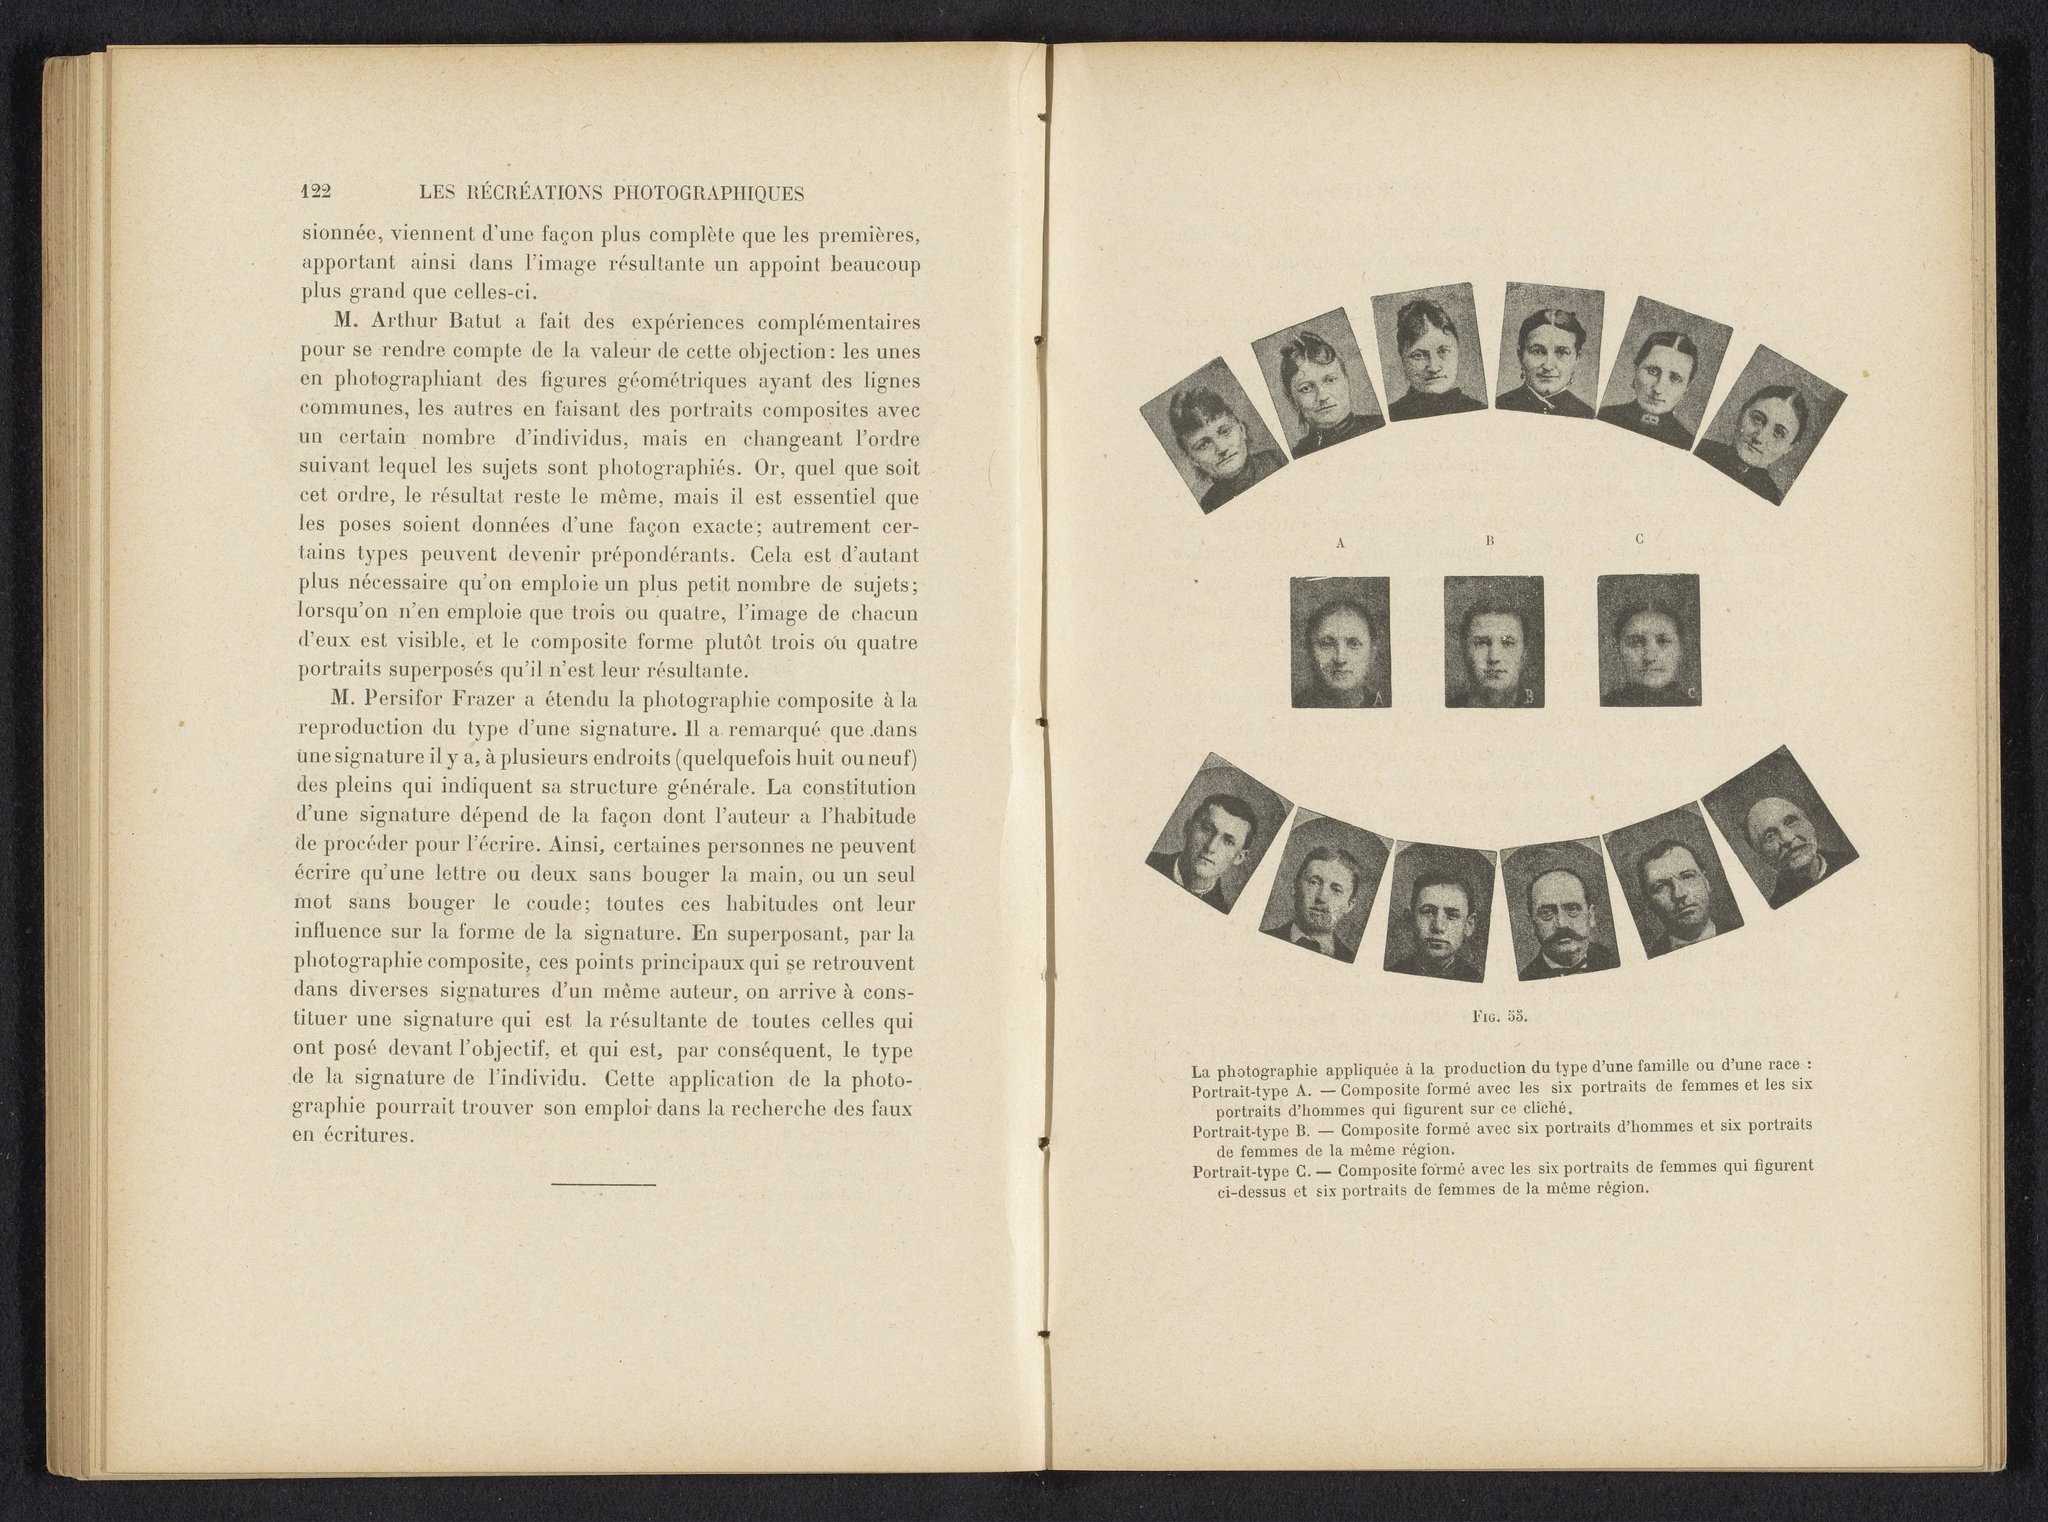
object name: photomechanical print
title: La photographie appliquée à la production du type d'une familie ou d'une rac (...)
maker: Anonymous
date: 1883-1893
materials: paper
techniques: autotype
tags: adult woman, adult man, historical persons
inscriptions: number: ‘Fig. 55.’